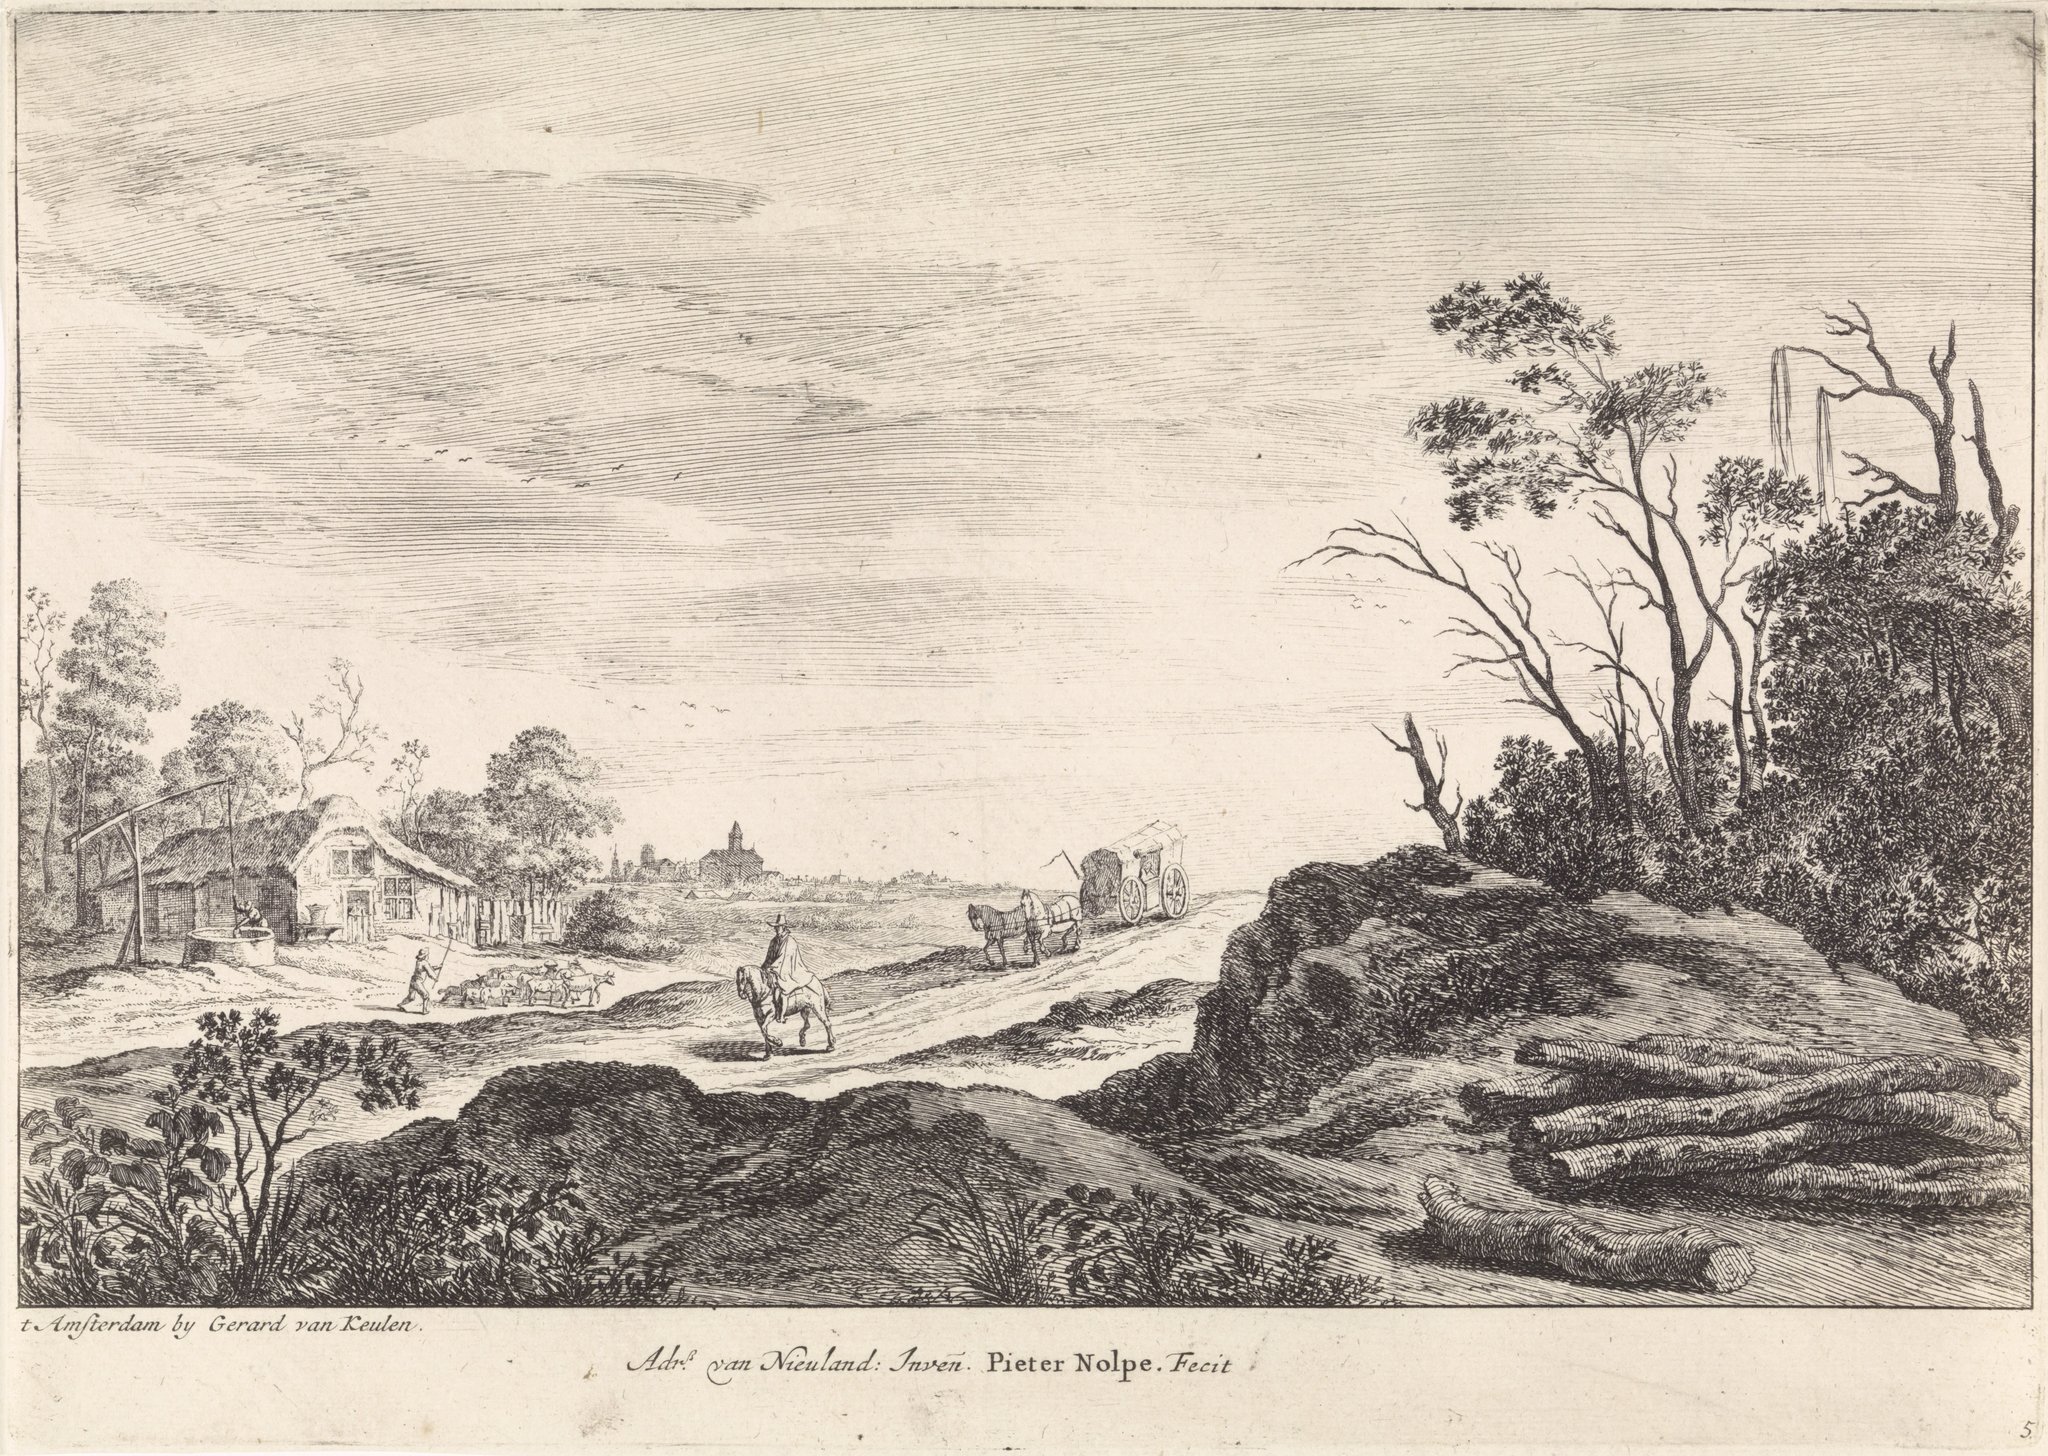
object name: print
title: Landschap met een boerderij aan een weg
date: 1688-1727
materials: paper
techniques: engraving, etching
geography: amsterdam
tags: riding a horse, ass, or mule; rider, horseman, well, road, path, farm or solitary house in landscape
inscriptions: collector's mark: Lugt 2228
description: Op een weg rijden een ruiter en een koets, die door twee paarden wordt getrokken. Links een boerderij, waarvoor een man water put en een boer met zijn vee loopt. Prent uit een serie landschappen.